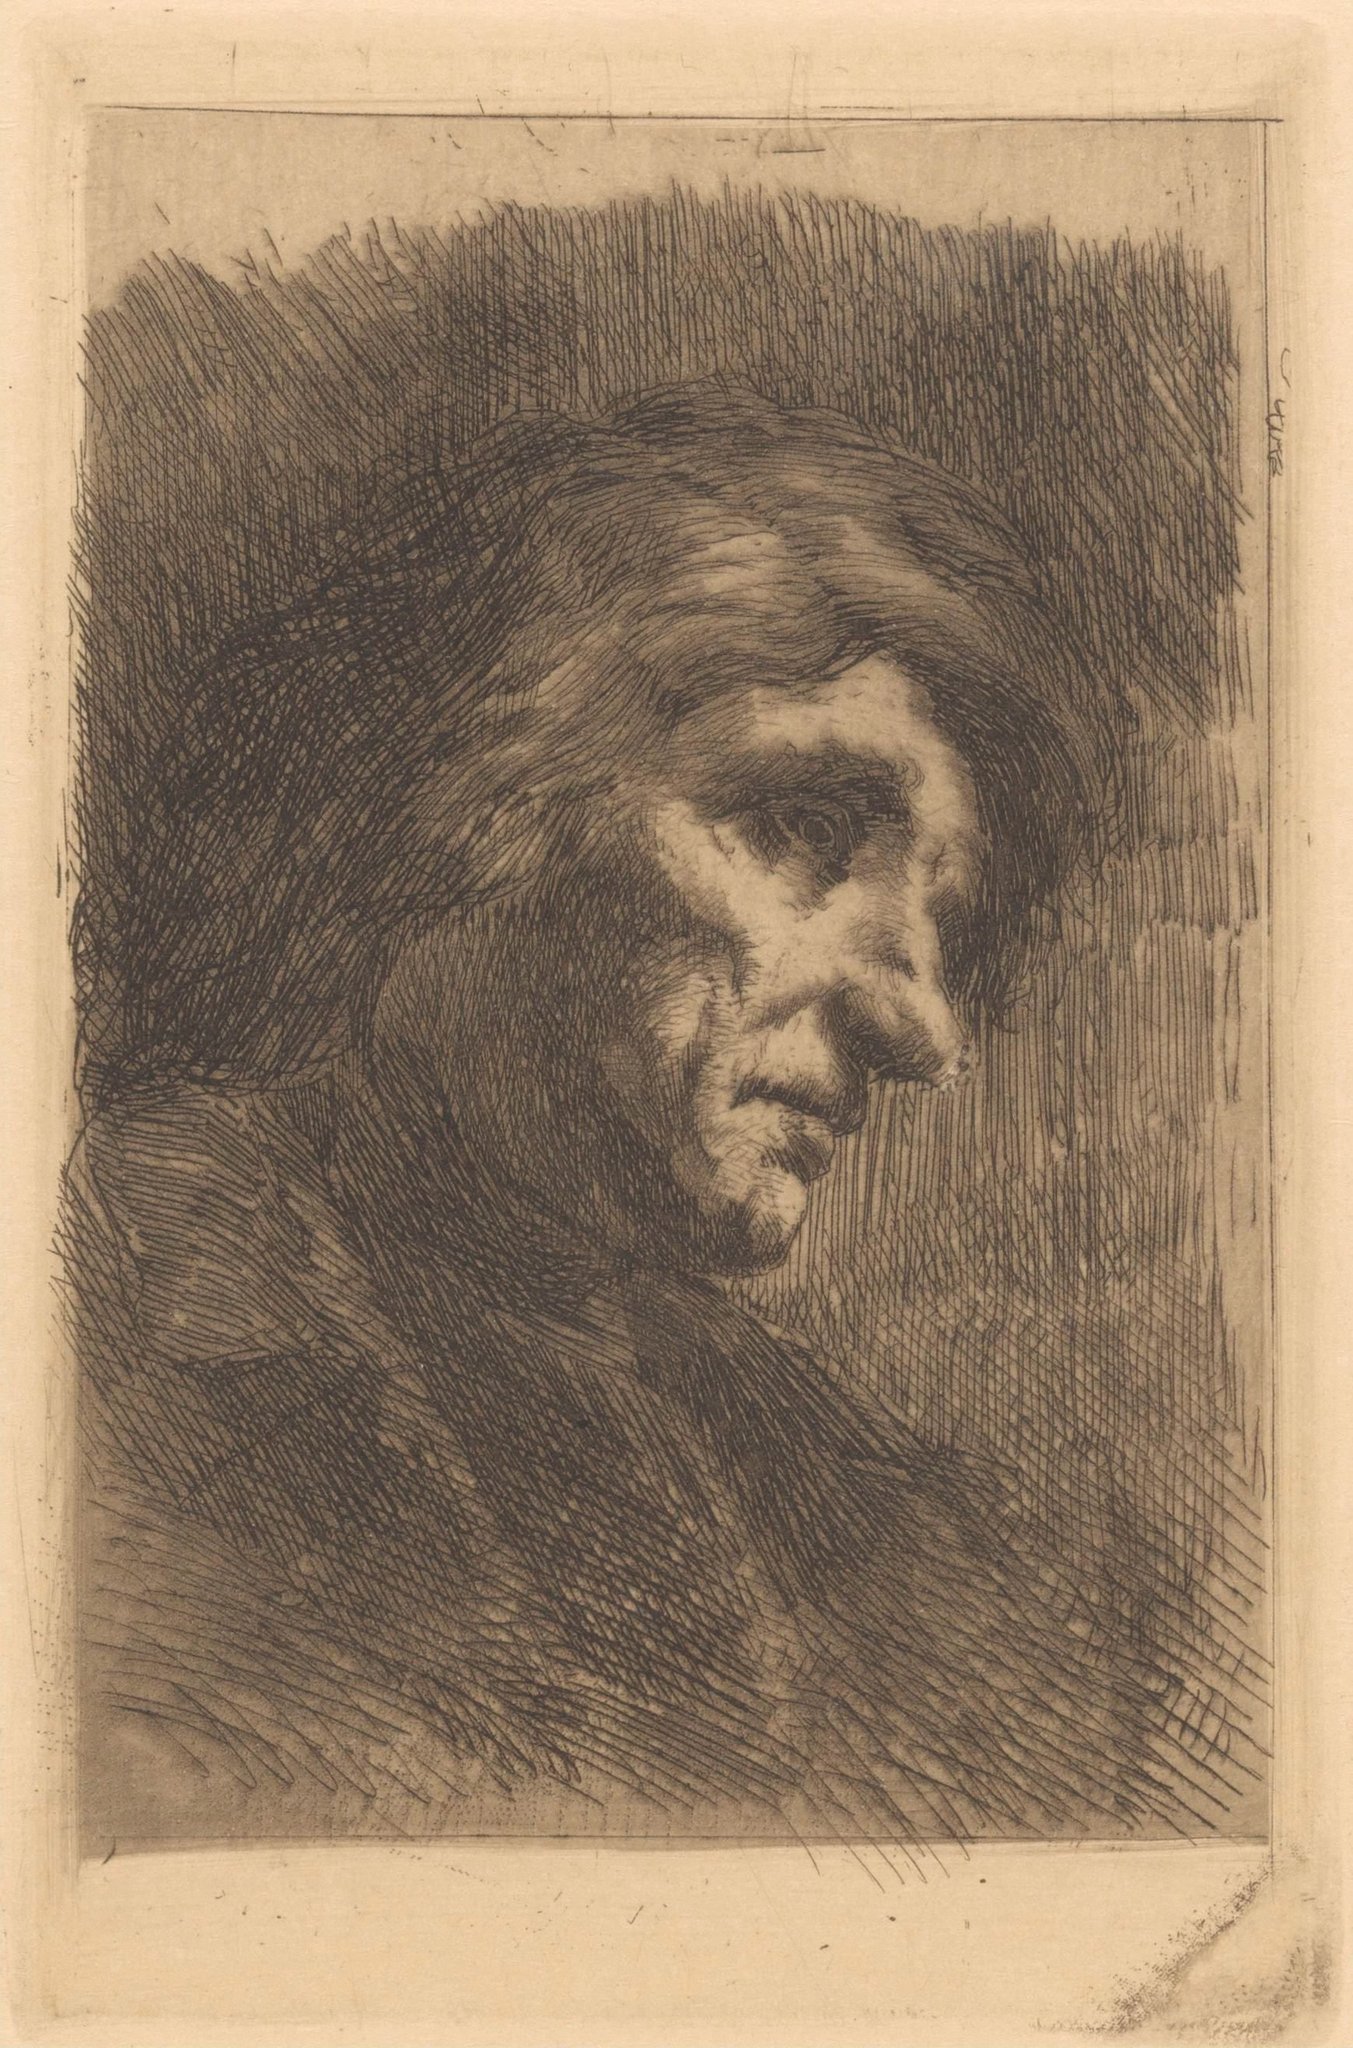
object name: print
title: Portret van een onbekende man met halflang haar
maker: frans hermesdorf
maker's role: painter, print maker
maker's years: 1854-1904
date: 1864-1904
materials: paper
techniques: aquatint, etching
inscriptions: collector's mark: Lugt 2228